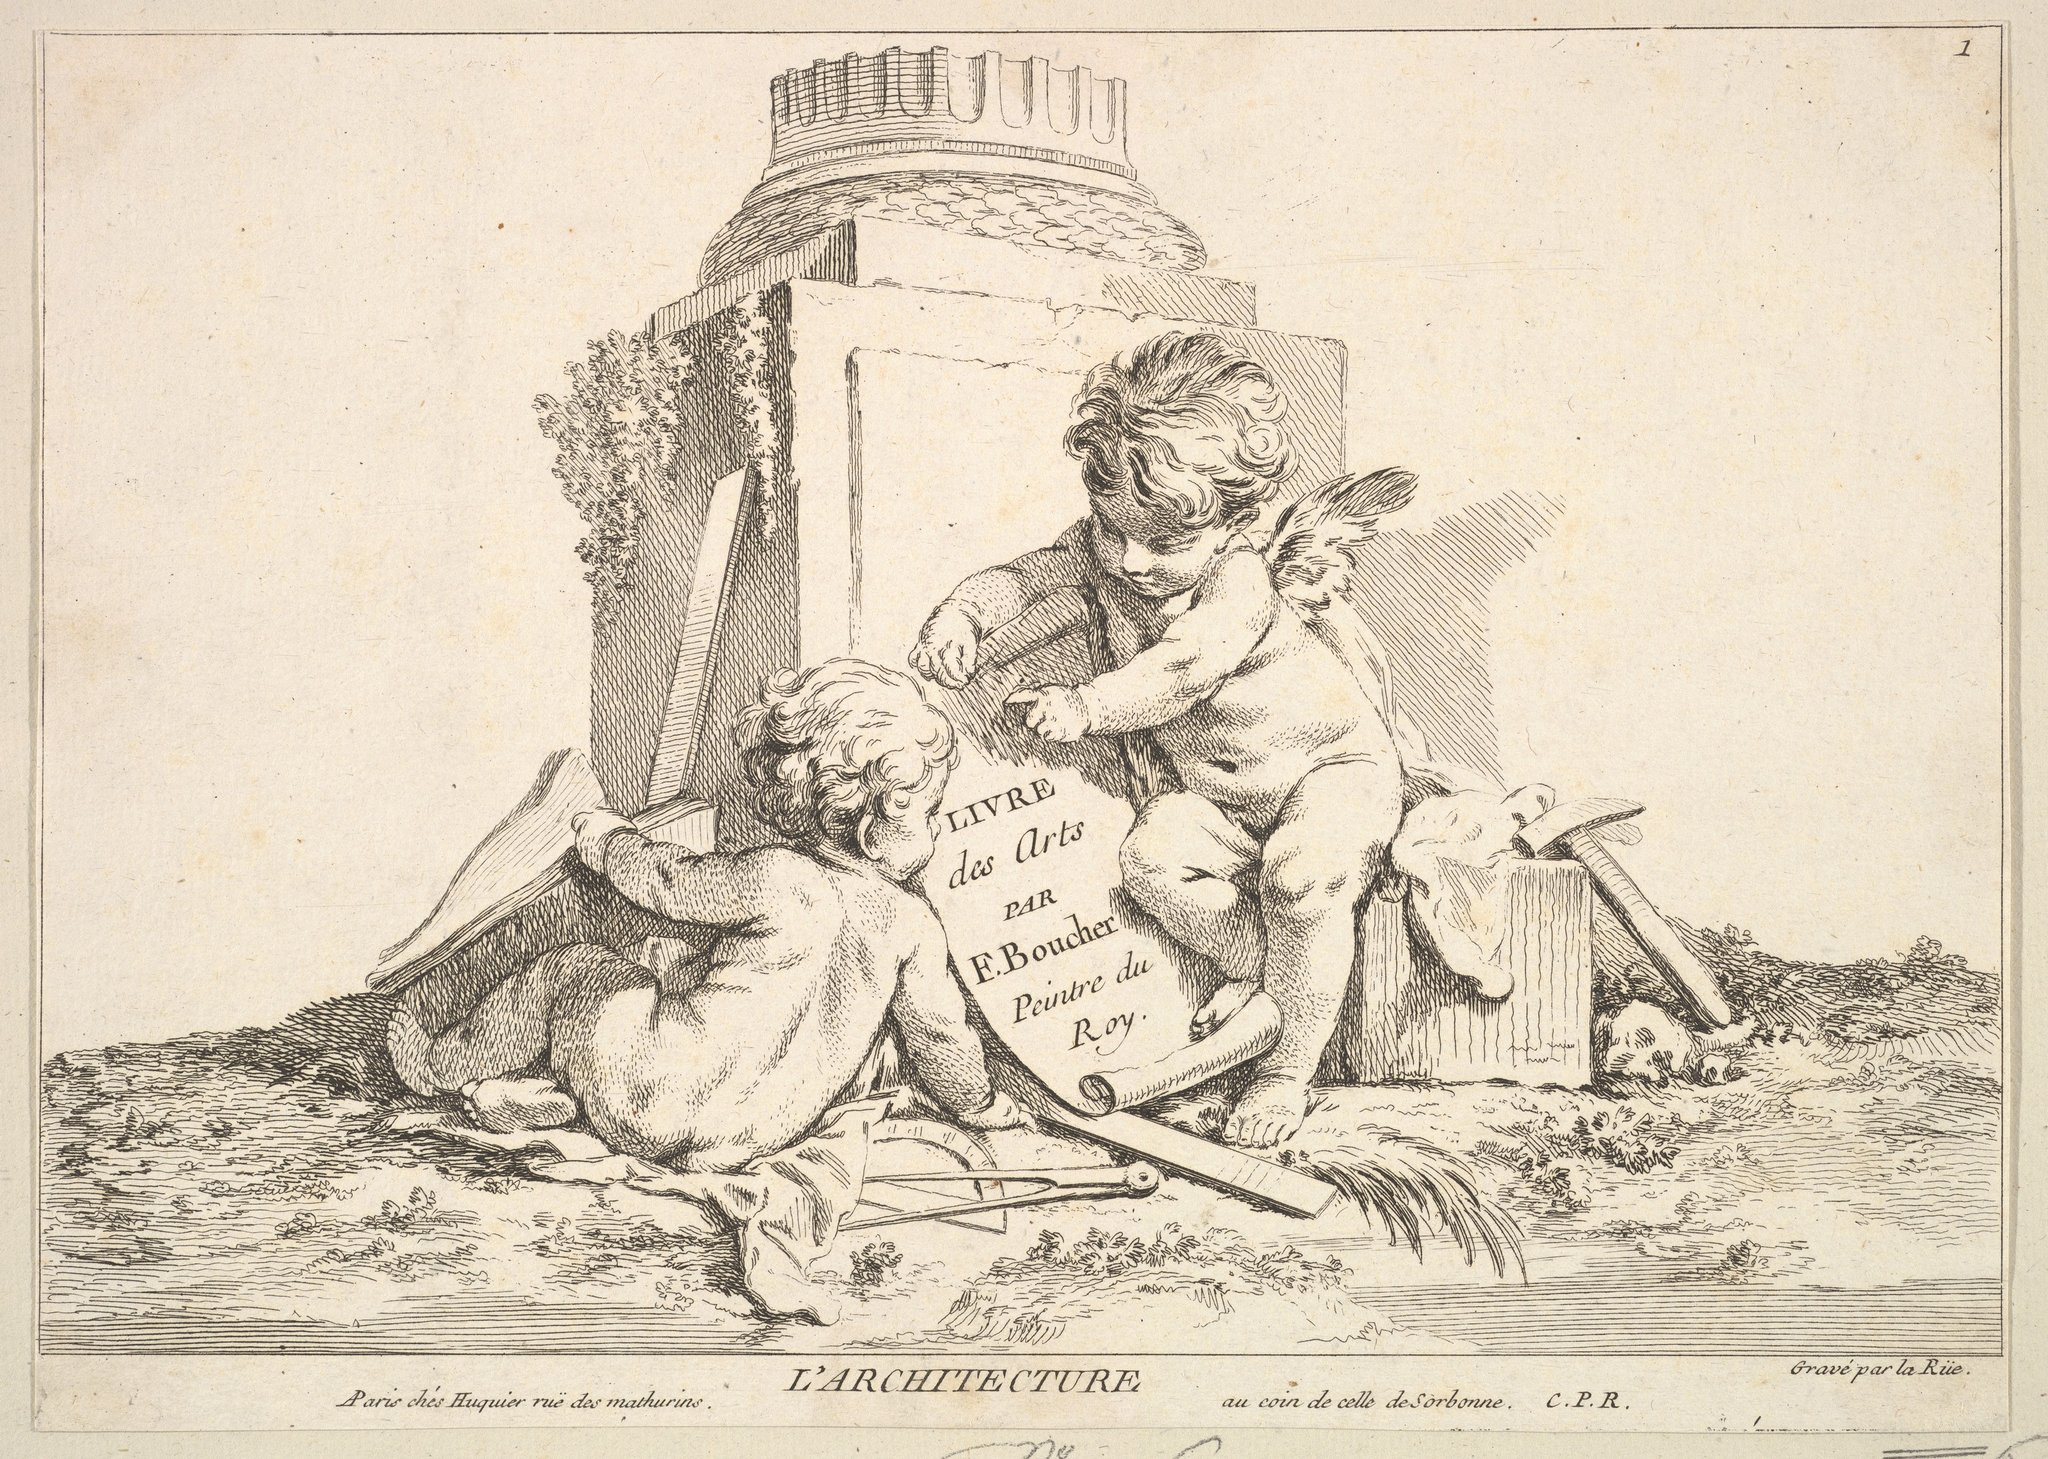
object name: print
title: Architecture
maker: louis félix de la rue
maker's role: artist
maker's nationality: french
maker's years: 1731-1765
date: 1731-1765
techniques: etching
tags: architecture,putti,hammers